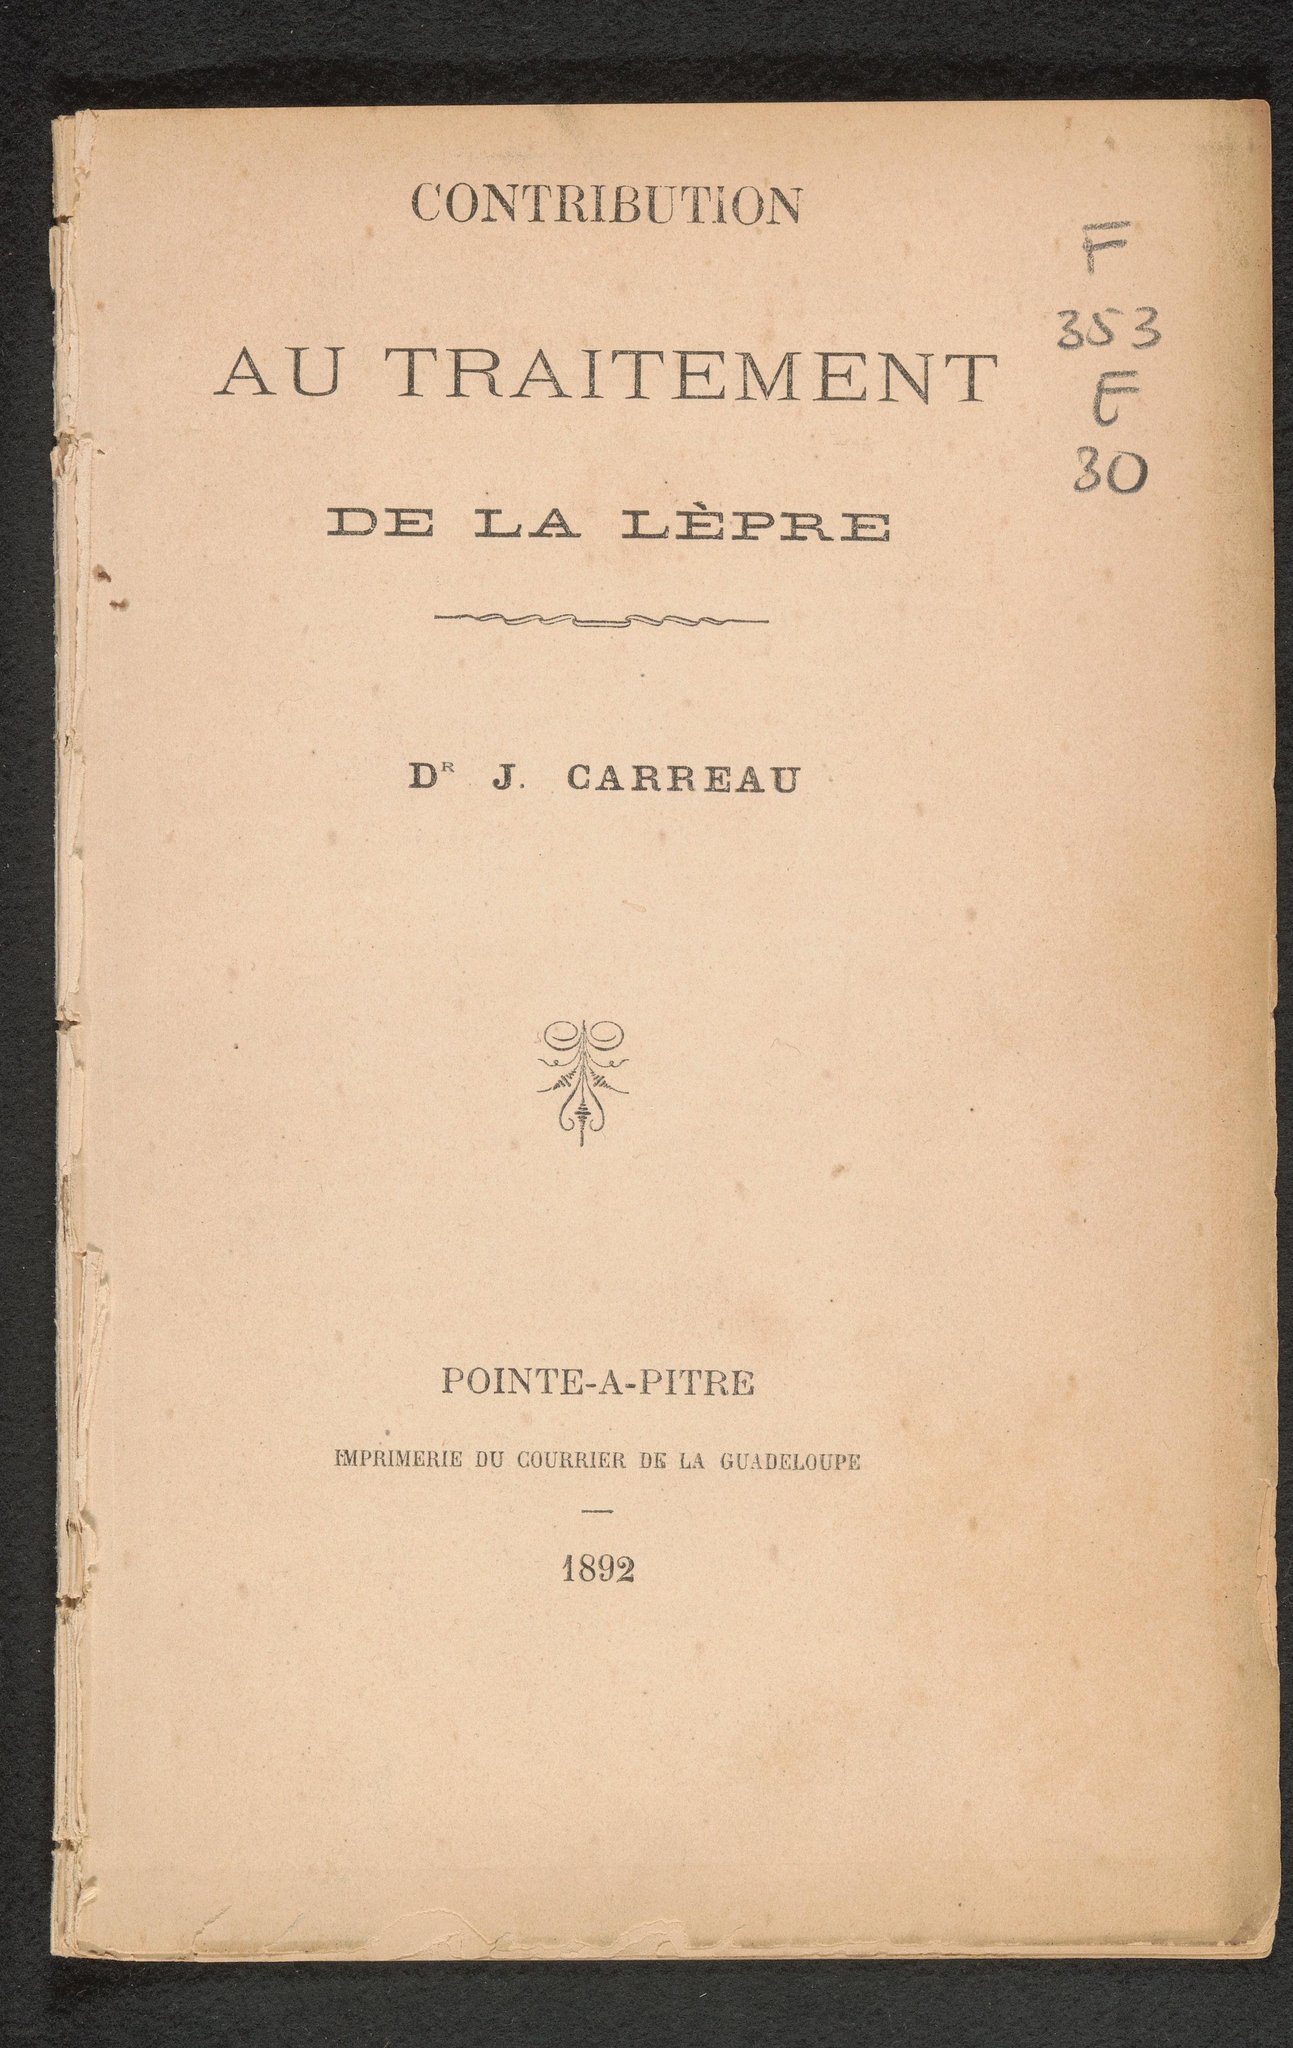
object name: book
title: Contribution au traitement de la lèpre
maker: j. carreau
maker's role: arts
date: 1892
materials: paper, photographic support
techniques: albumen print, printing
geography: pointe-à-pitre